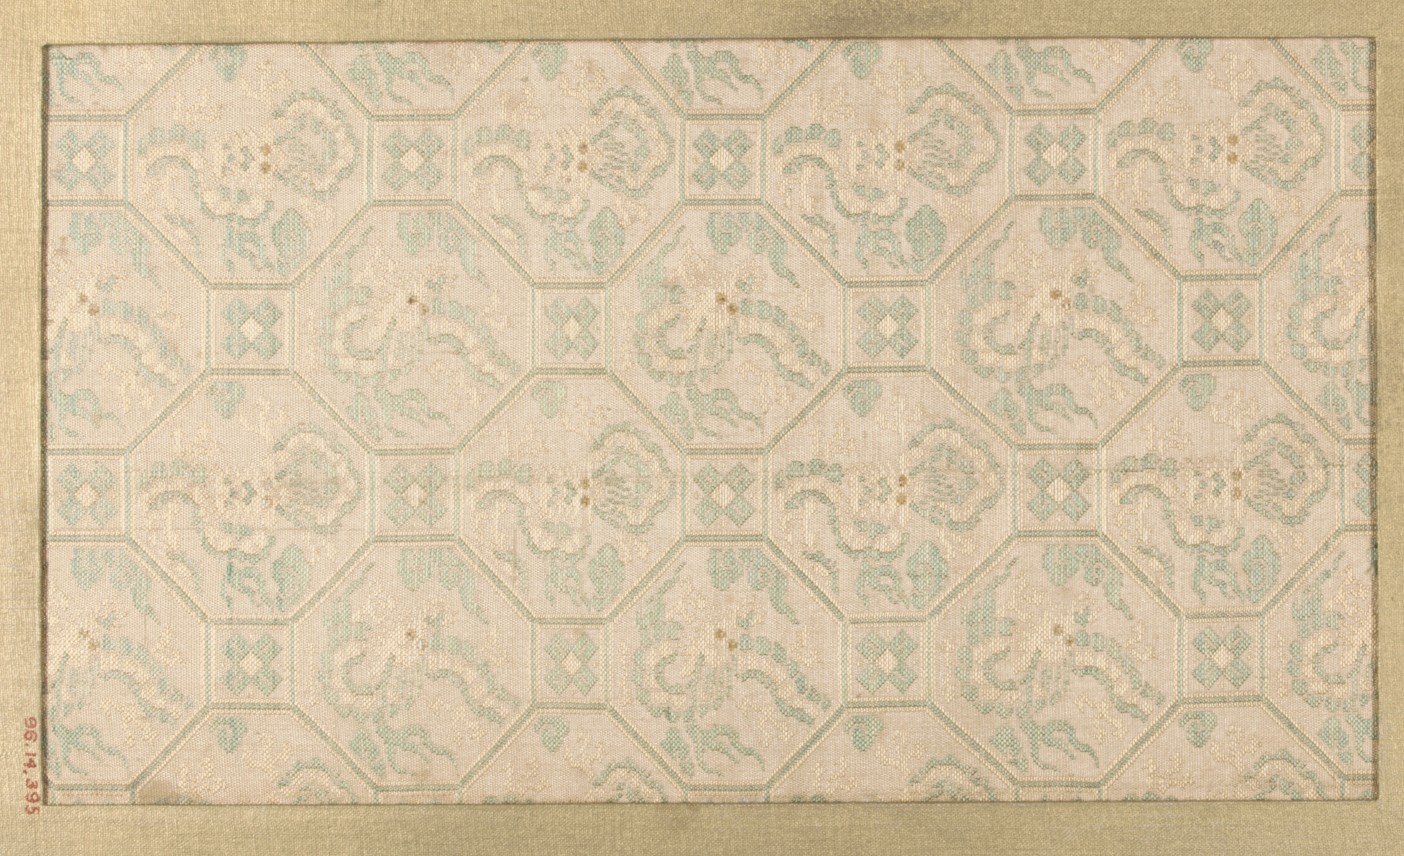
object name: piece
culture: japanese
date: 1701-1900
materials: silk